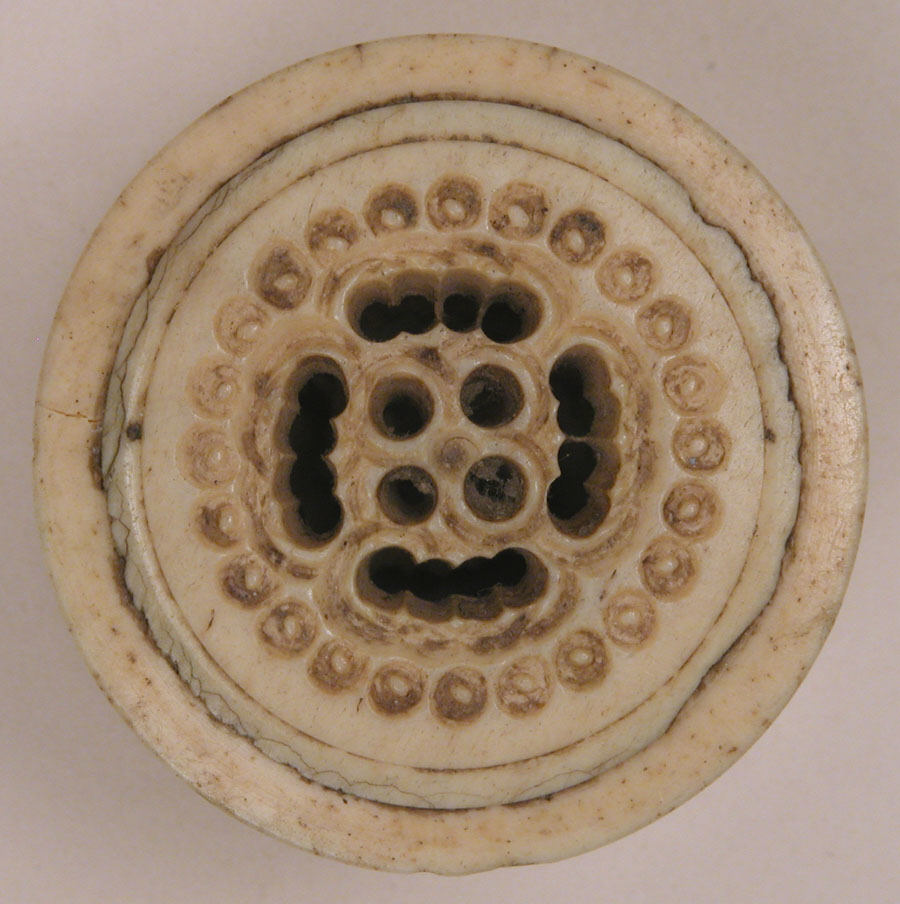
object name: spool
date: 201-1200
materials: bone, paint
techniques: incising, inlay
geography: egypt